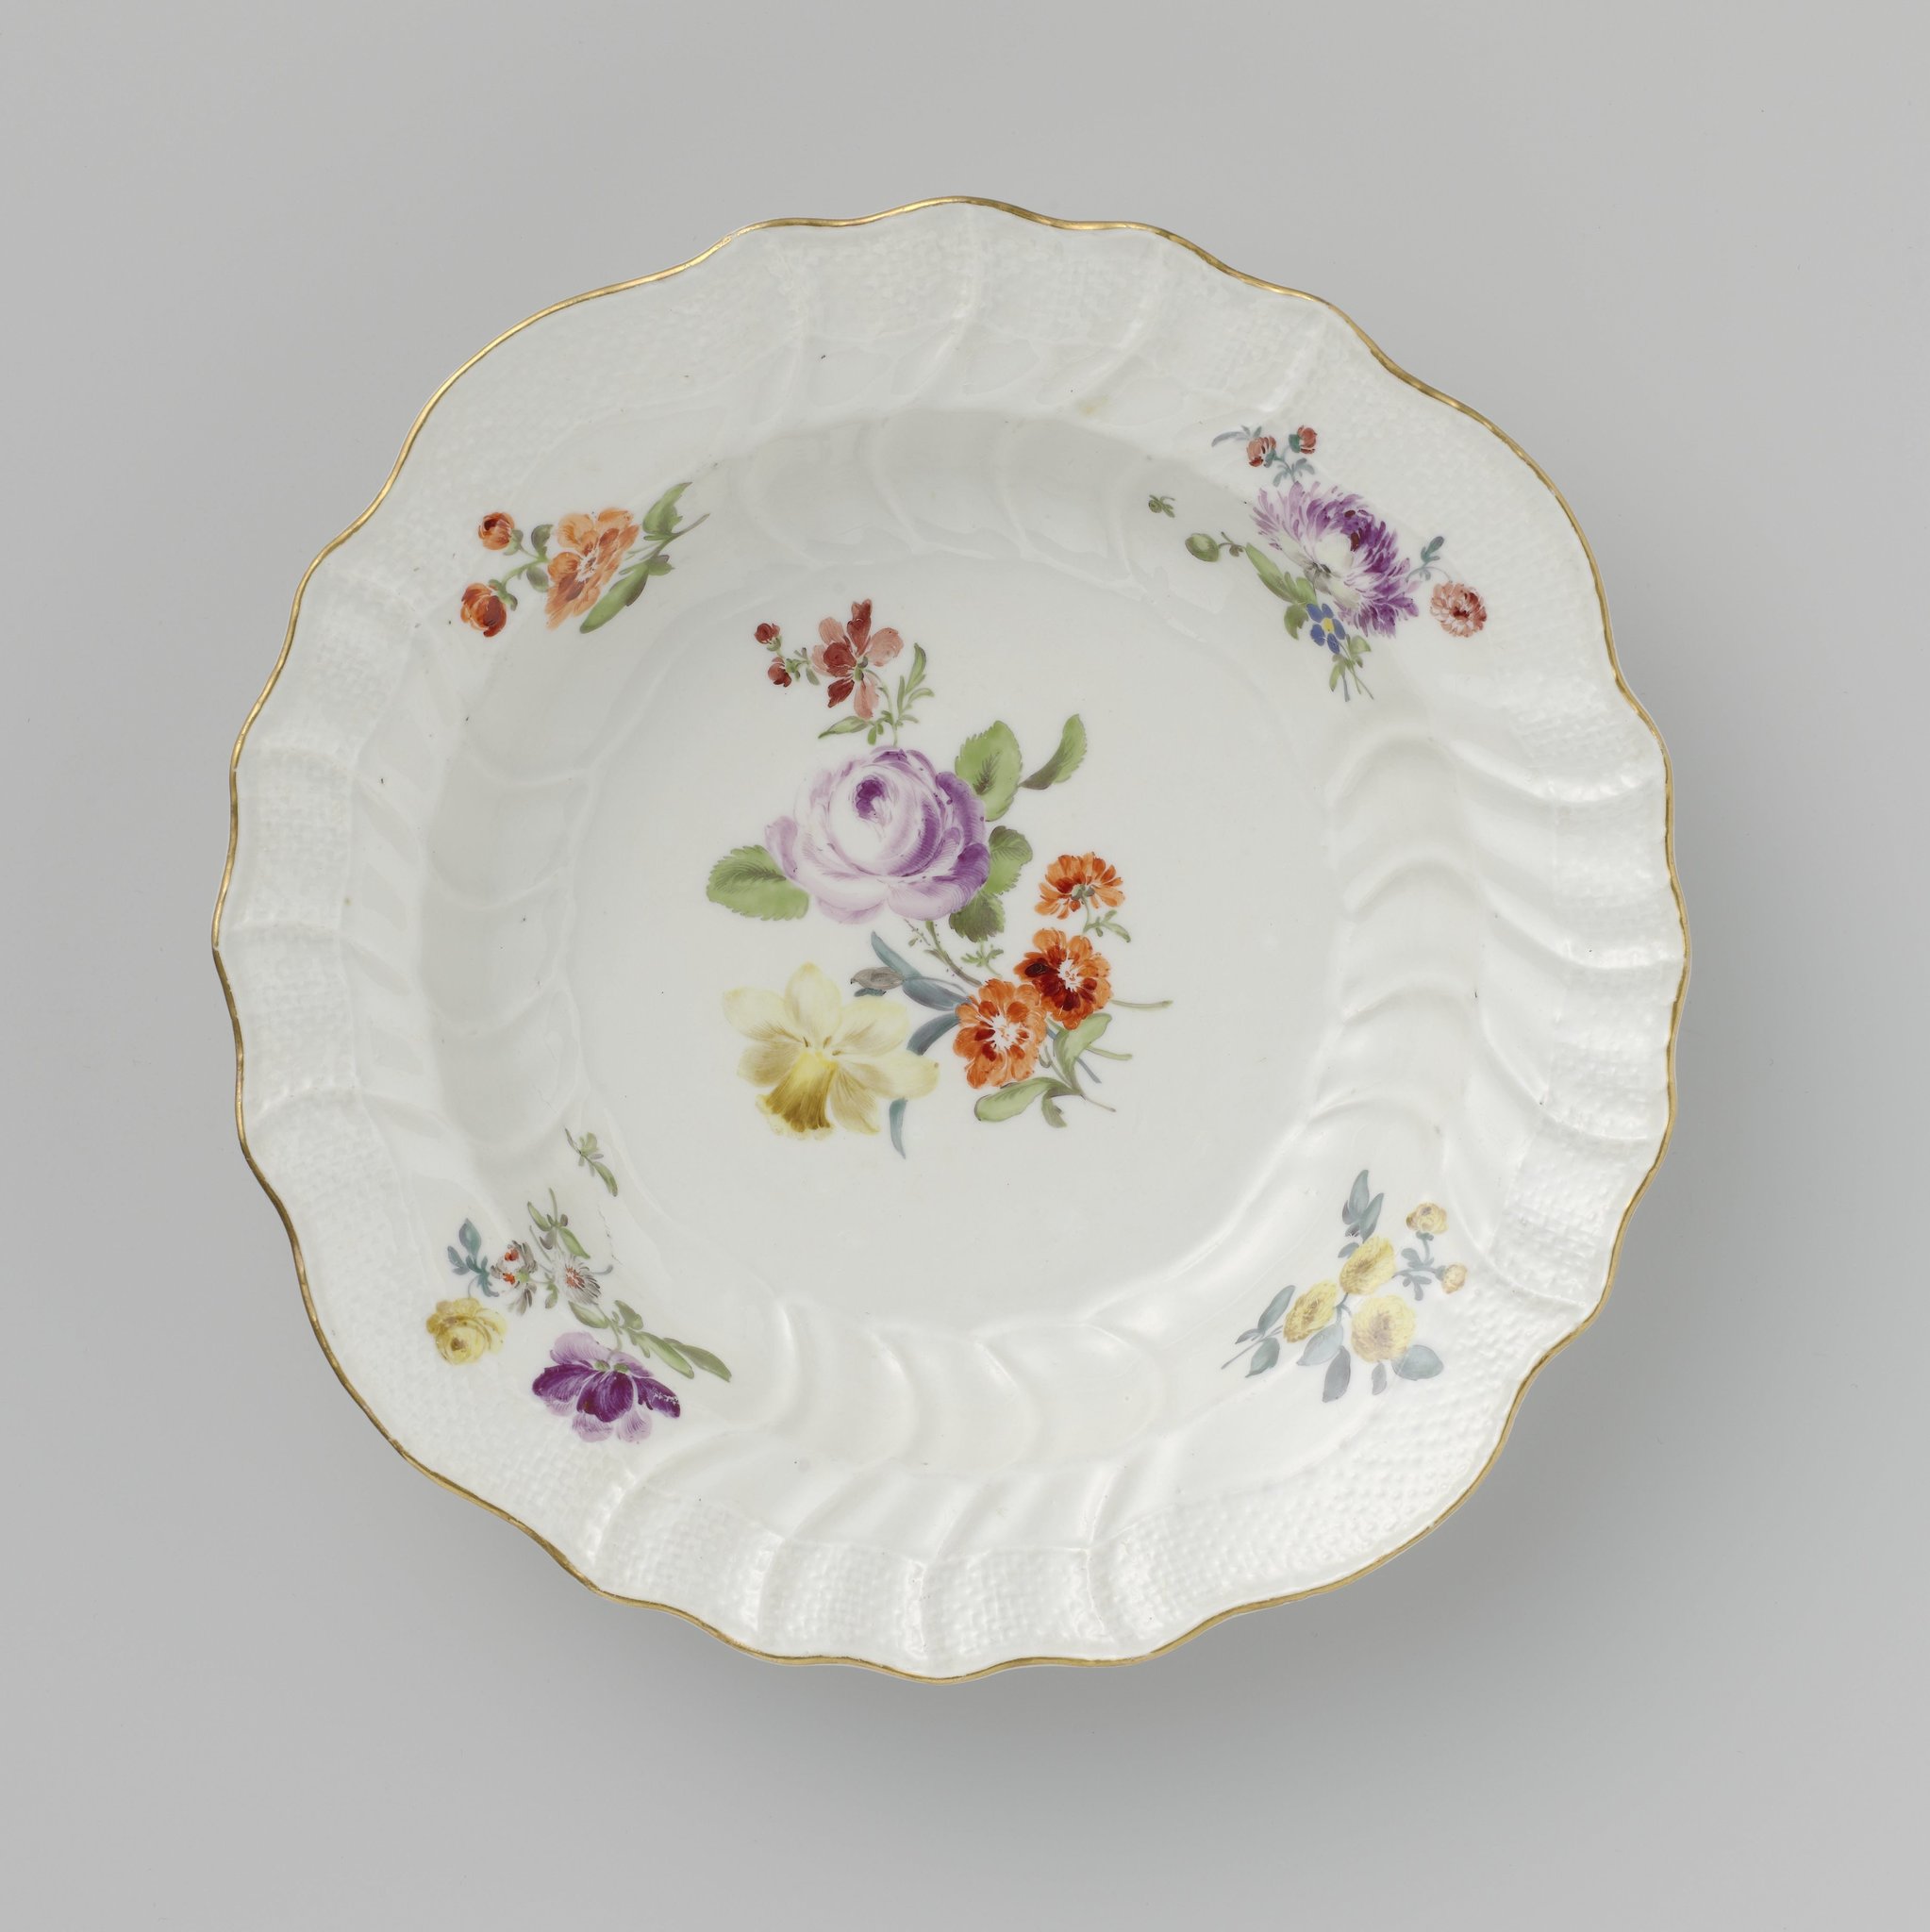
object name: eating drinking utensil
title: Bord, veelkleurig beschilderd met Deutsche Blumen, insekten en vruchten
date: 1750-1760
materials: porcelain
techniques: painted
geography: meissen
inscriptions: factory mark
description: Rond soepbord van beschilderd porselein. Het bord is beschilderd met Deutsche Blumen, insekten en vruchten. De rand is in reliëf versierd met het Neuozier-patroon. Het bord is gemerkt en hoort bij een servies (BK-17474-1 t/m BK-17474-253).